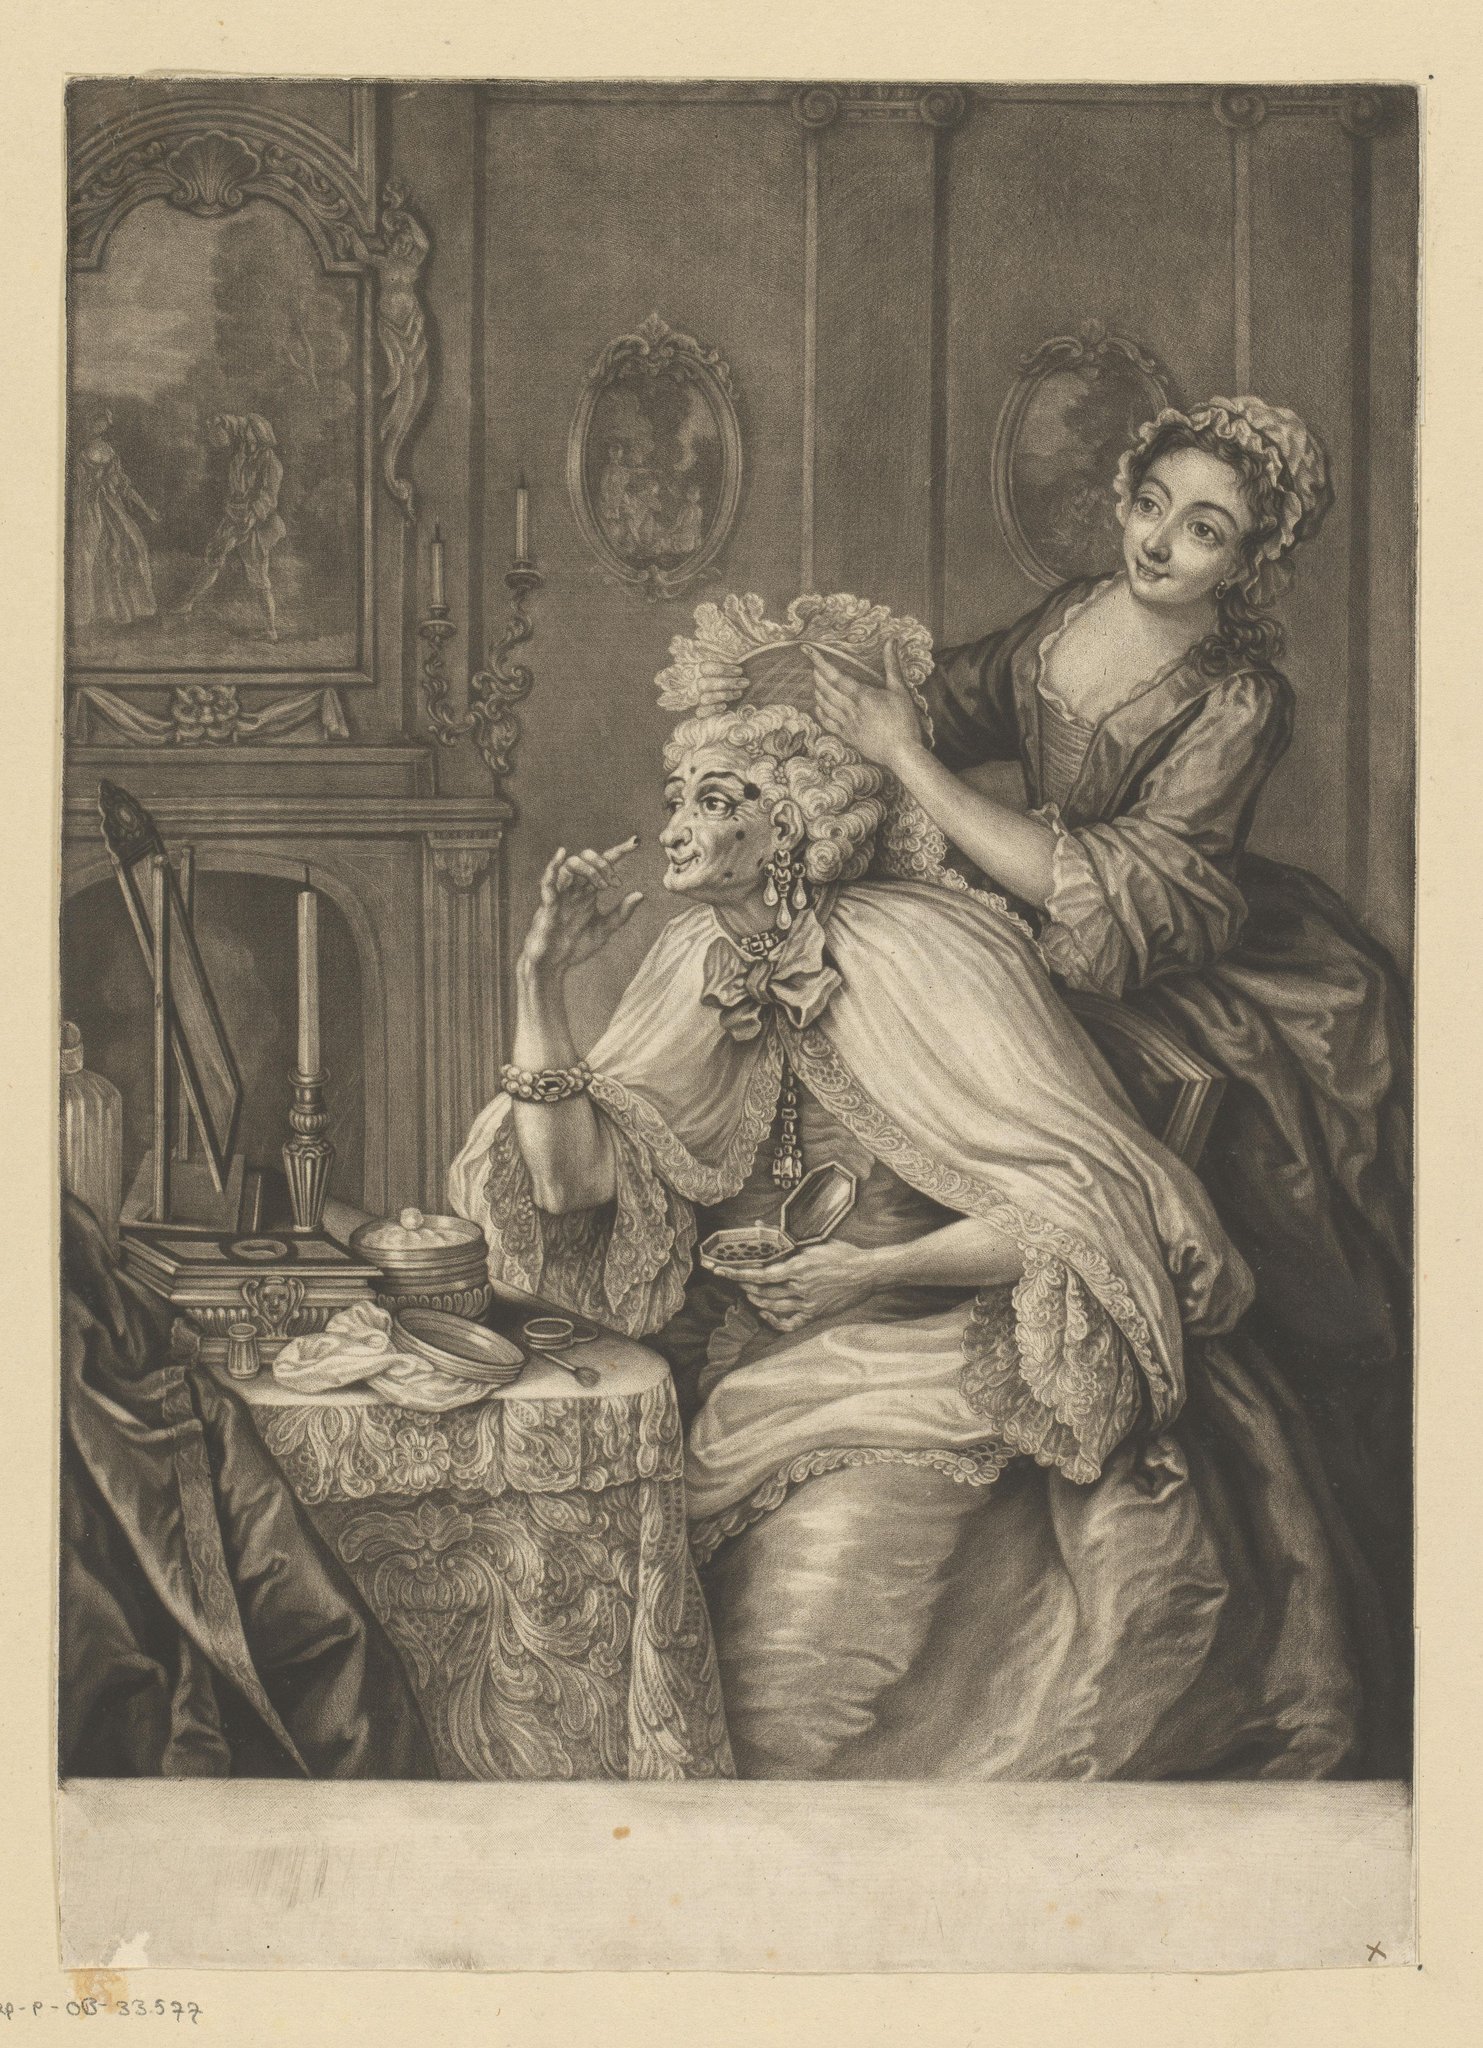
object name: print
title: Oude vrouw aan het toilet met kamenier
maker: Anonymous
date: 1680-1720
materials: paper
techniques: mezzotint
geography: england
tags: making up - aa - (for) women, mirror - aa - (for) women, maid ~ house personnel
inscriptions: collector's mark: Lugt 240